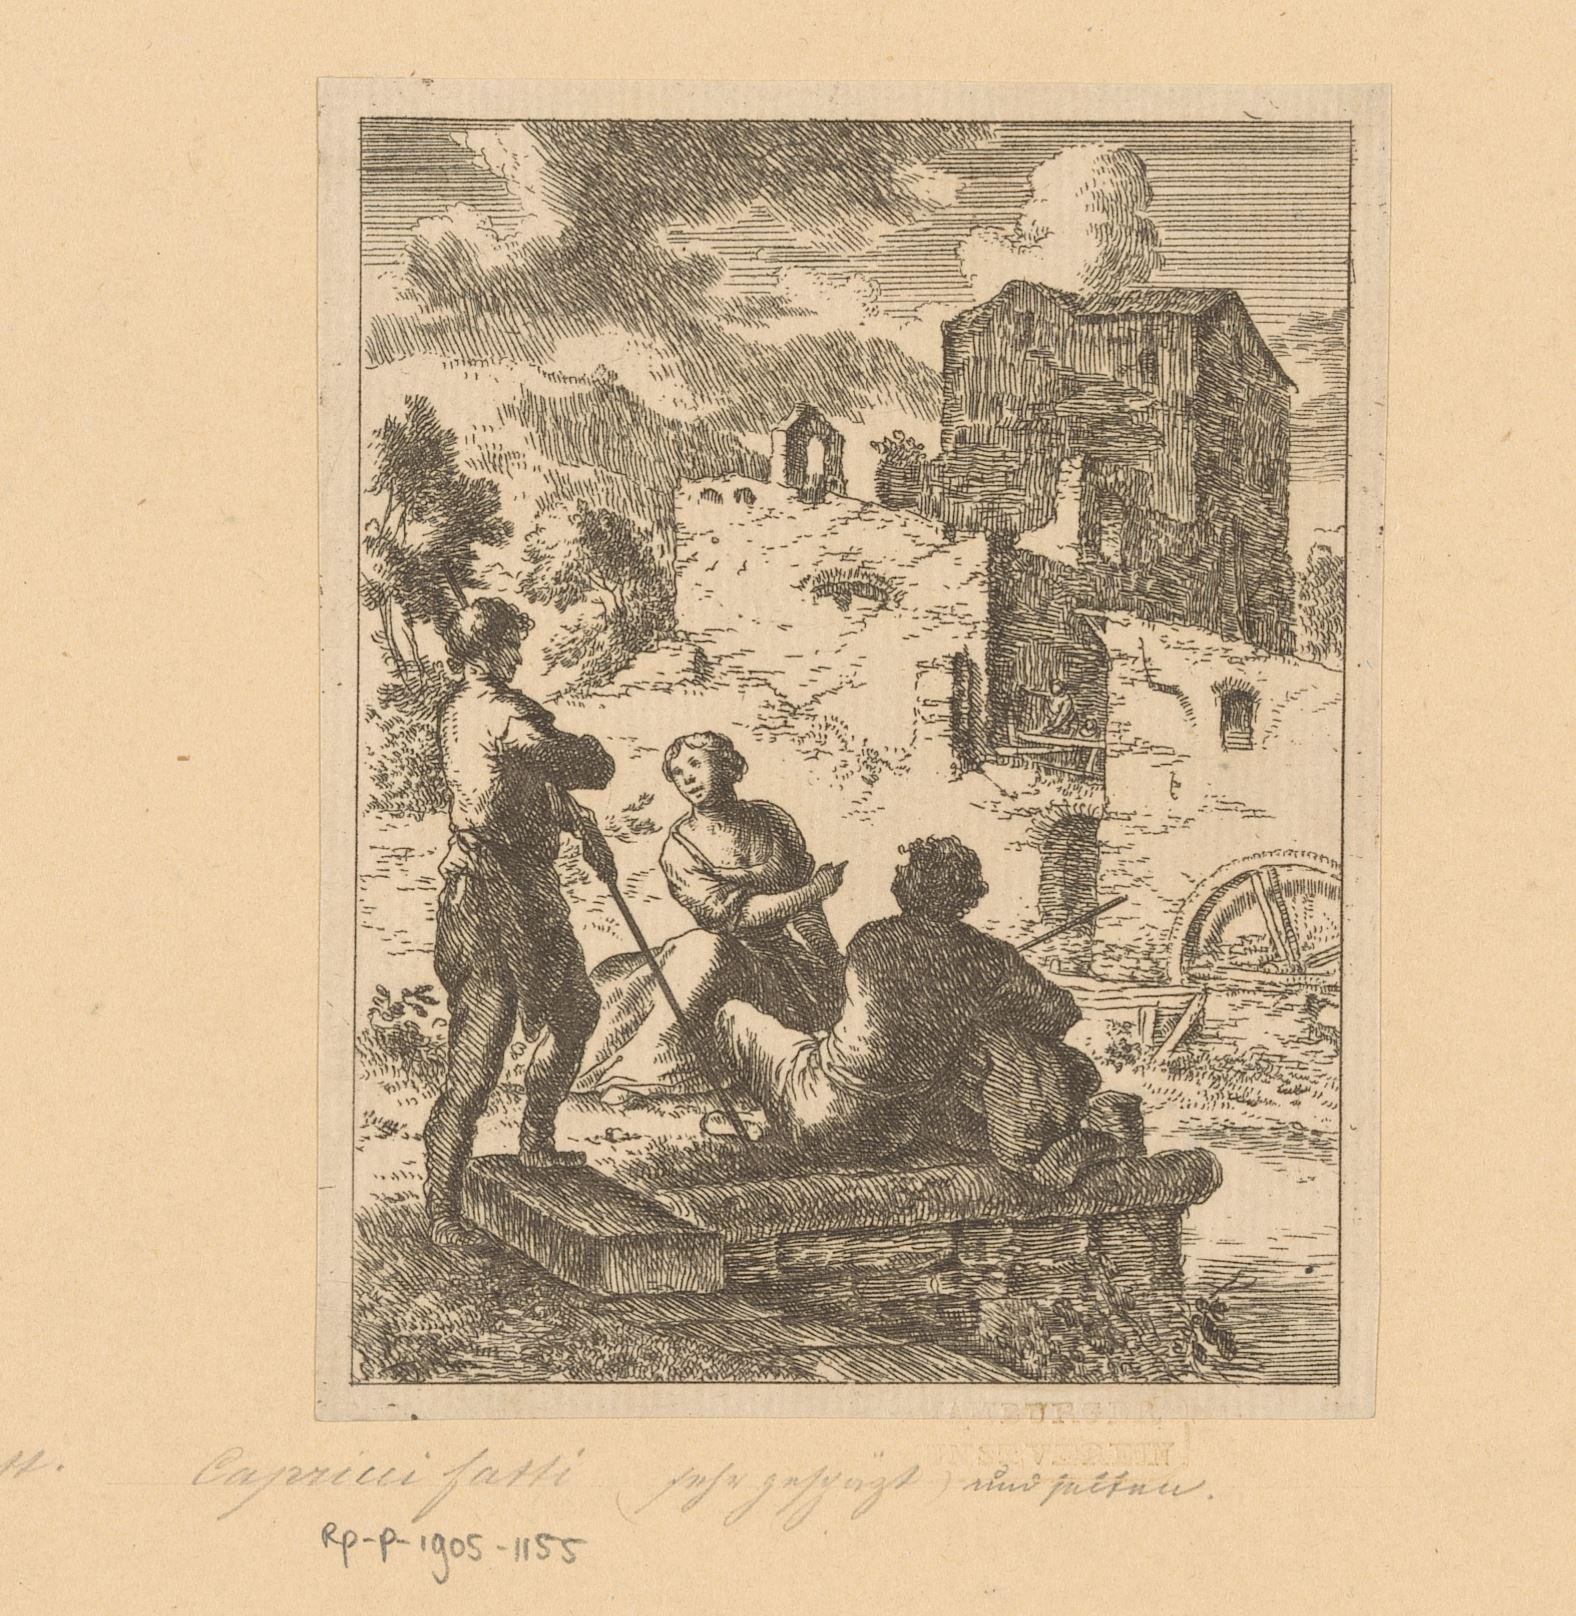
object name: print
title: Drie herders rustend in een landschap met ruïnes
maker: franz de paula ferg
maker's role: draughtsman, painter, print maker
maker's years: 1689-1740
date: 1699-1740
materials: paper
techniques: etching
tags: herding, herdsman, herdswoman, shepherd, shepherdess, cowherd, etc., landscape with ruins, watermill in landscape, resting - bb - out of doors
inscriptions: collector's mark: Lugt 2228, collector's mark: Lugt 1236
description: Onderdeel van een serie van zeven prenten.